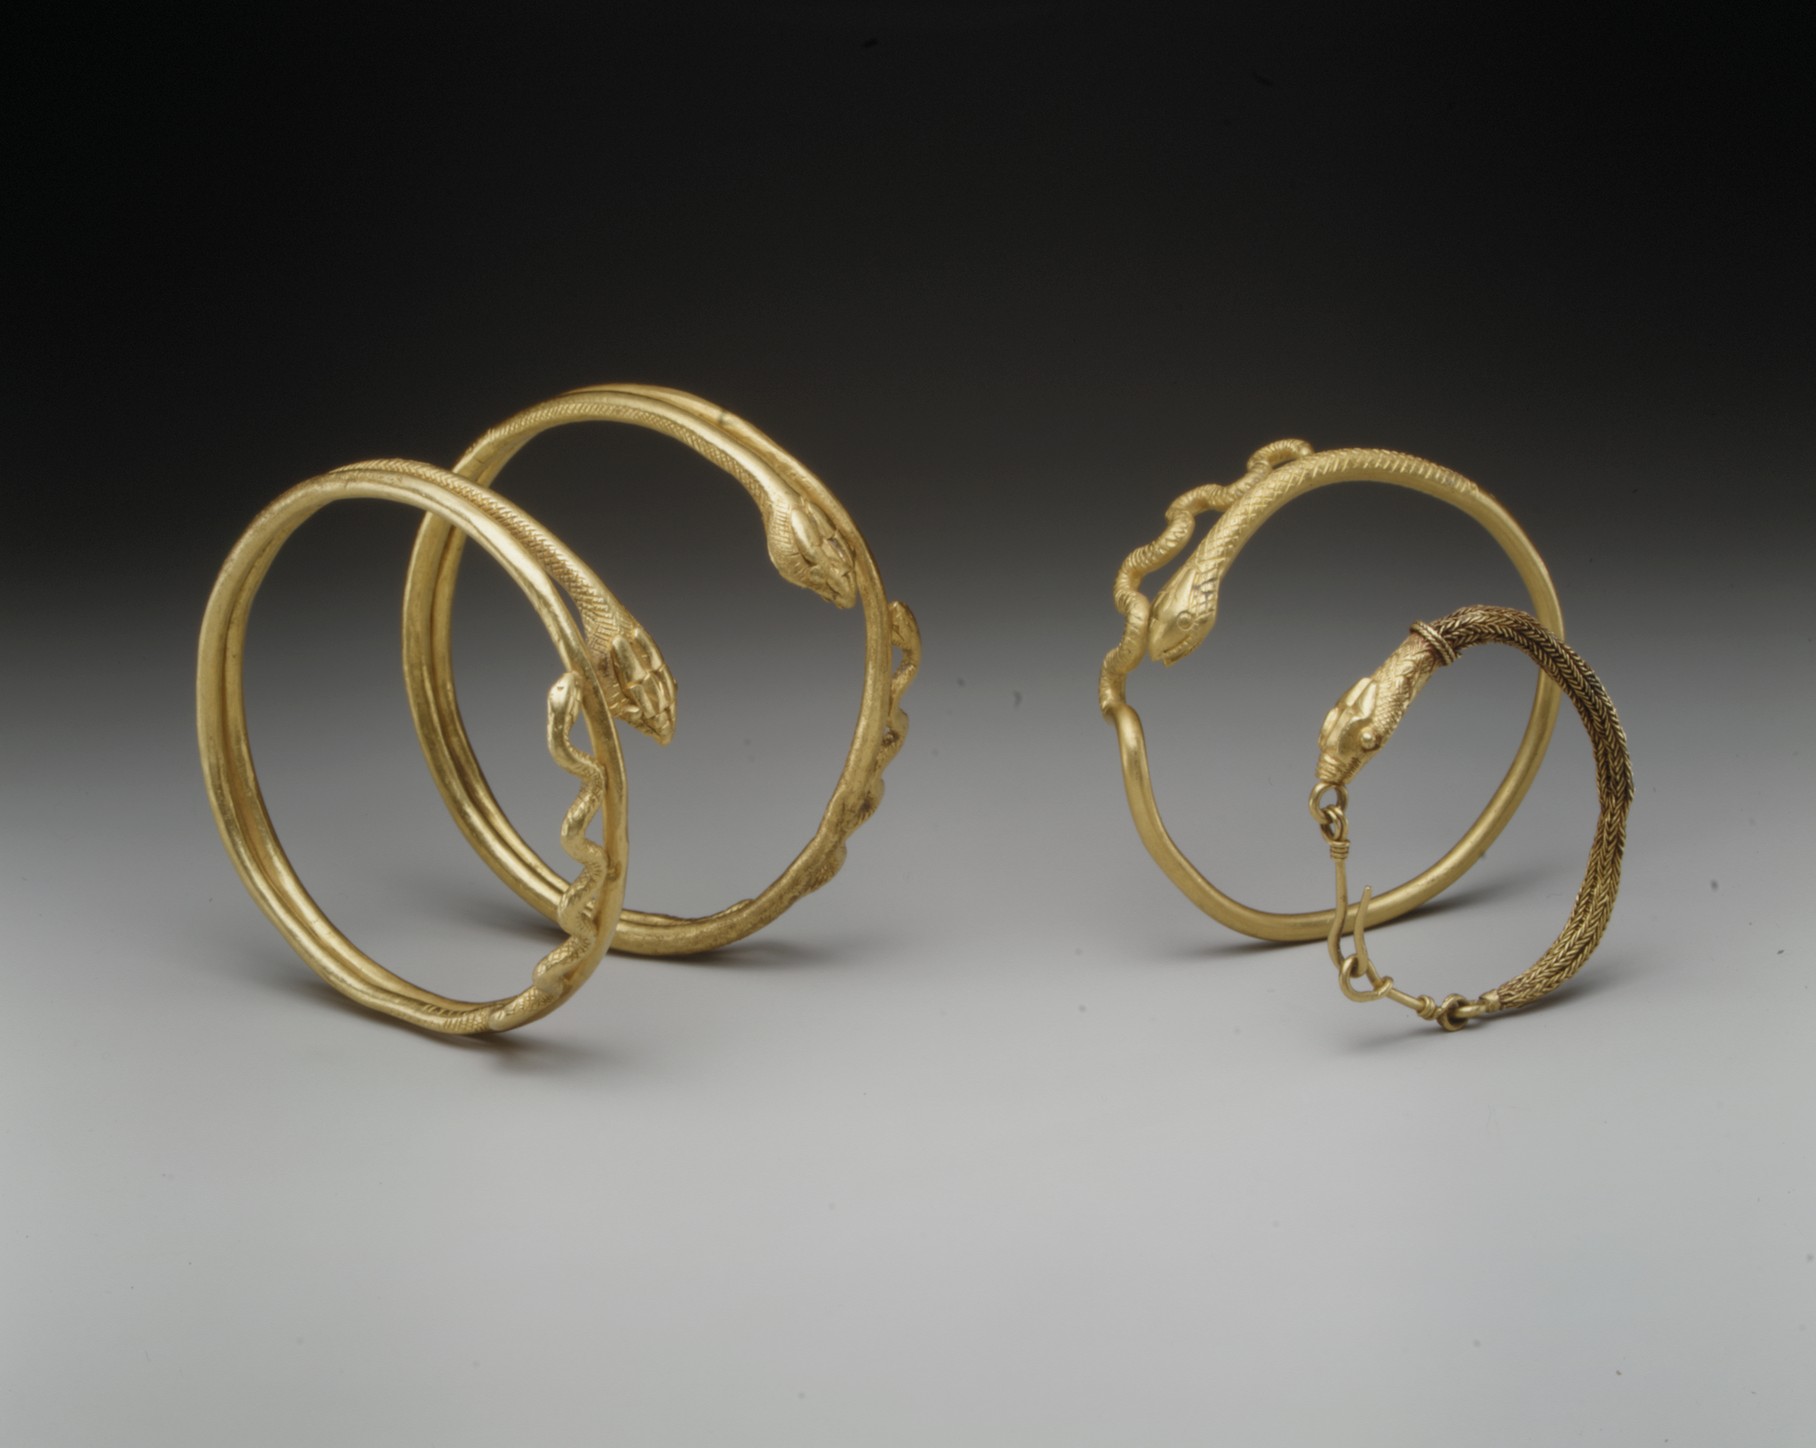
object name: bracelet, snake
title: Snake bracelet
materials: gold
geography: egypt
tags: snakes